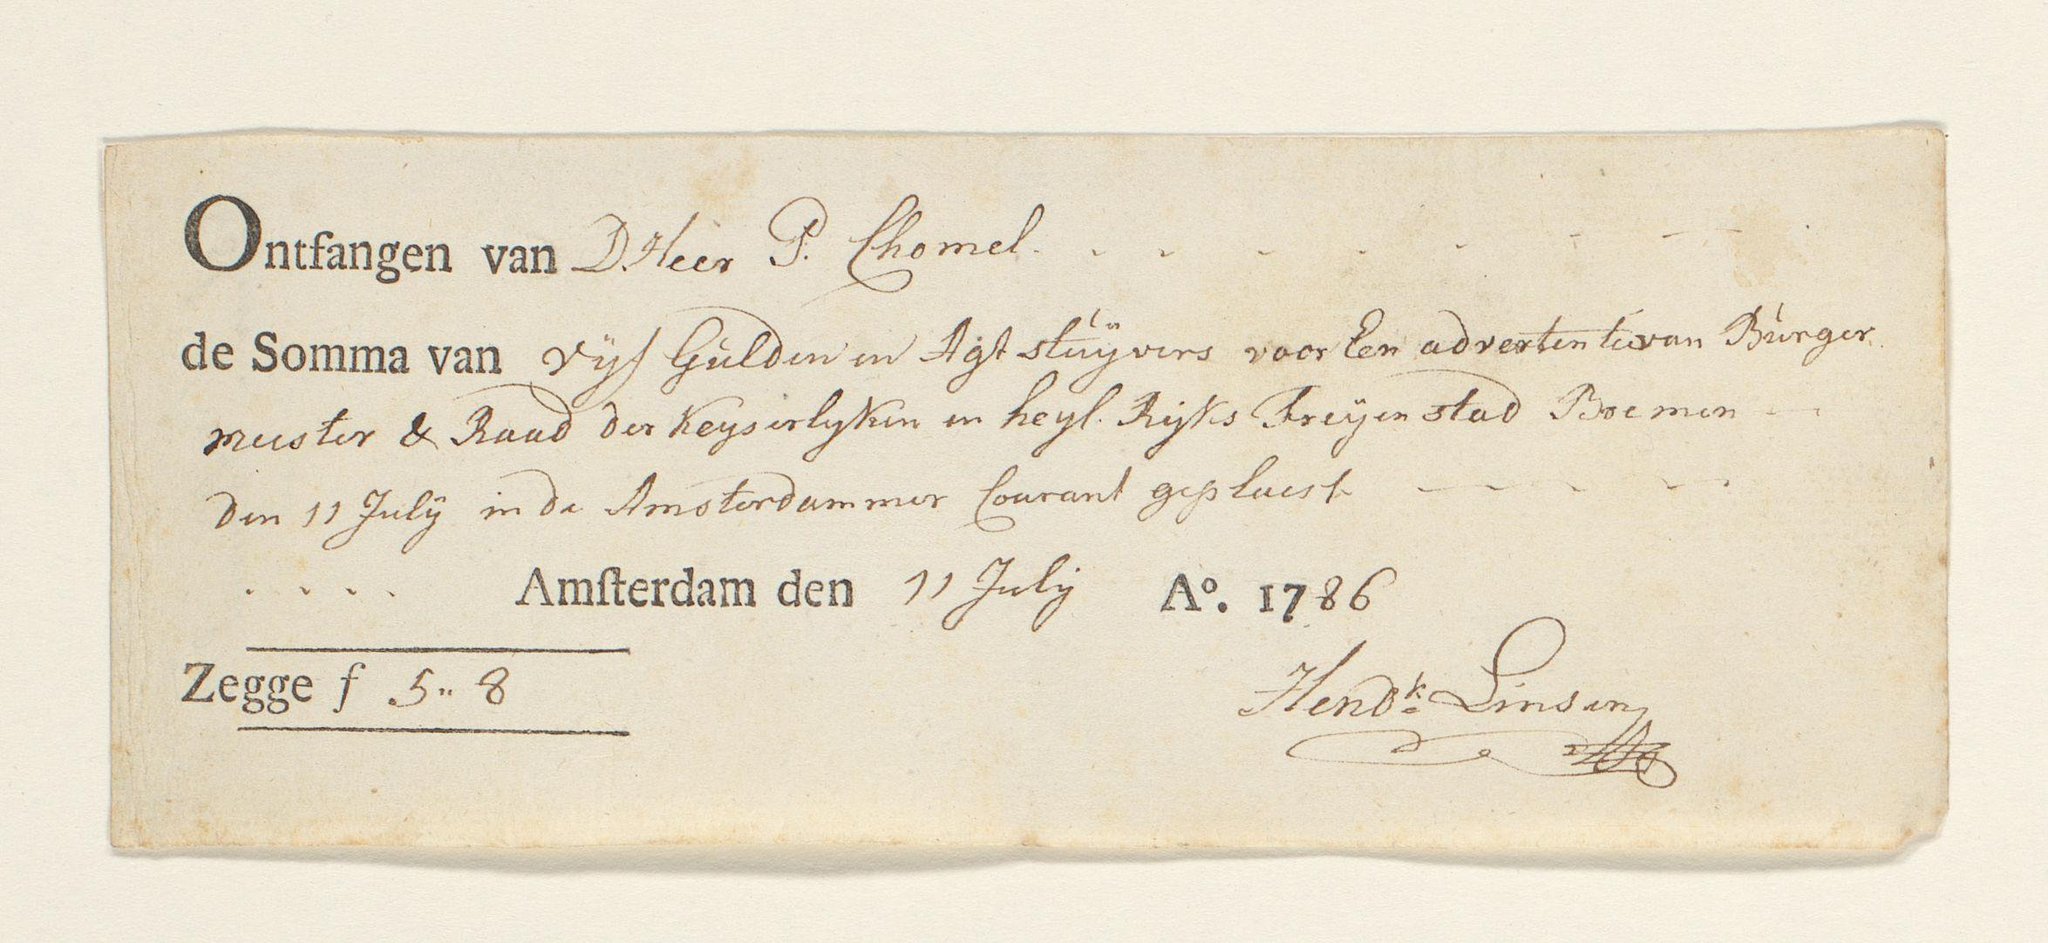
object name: ontvangstbewijs, kwitantie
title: Kwitantie voor P. Chomel, Amsterdam, 1786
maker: hendrik linsen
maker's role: publisher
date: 1786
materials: ink, paper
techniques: letterpress printing, writing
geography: amsterdam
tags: advertising, receipt, newspaper, news-sheet, amsterdam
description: Kwitantie voor de heer P. Chomel, Amsterdam, 11 juli 1786, voor de betaling van een advertentie in de Amsterdammer Courant van 11 juli 1786, ondertekend door Hend.k Linsen. Voorgedrukt briefje, ingevuld met handschrift.